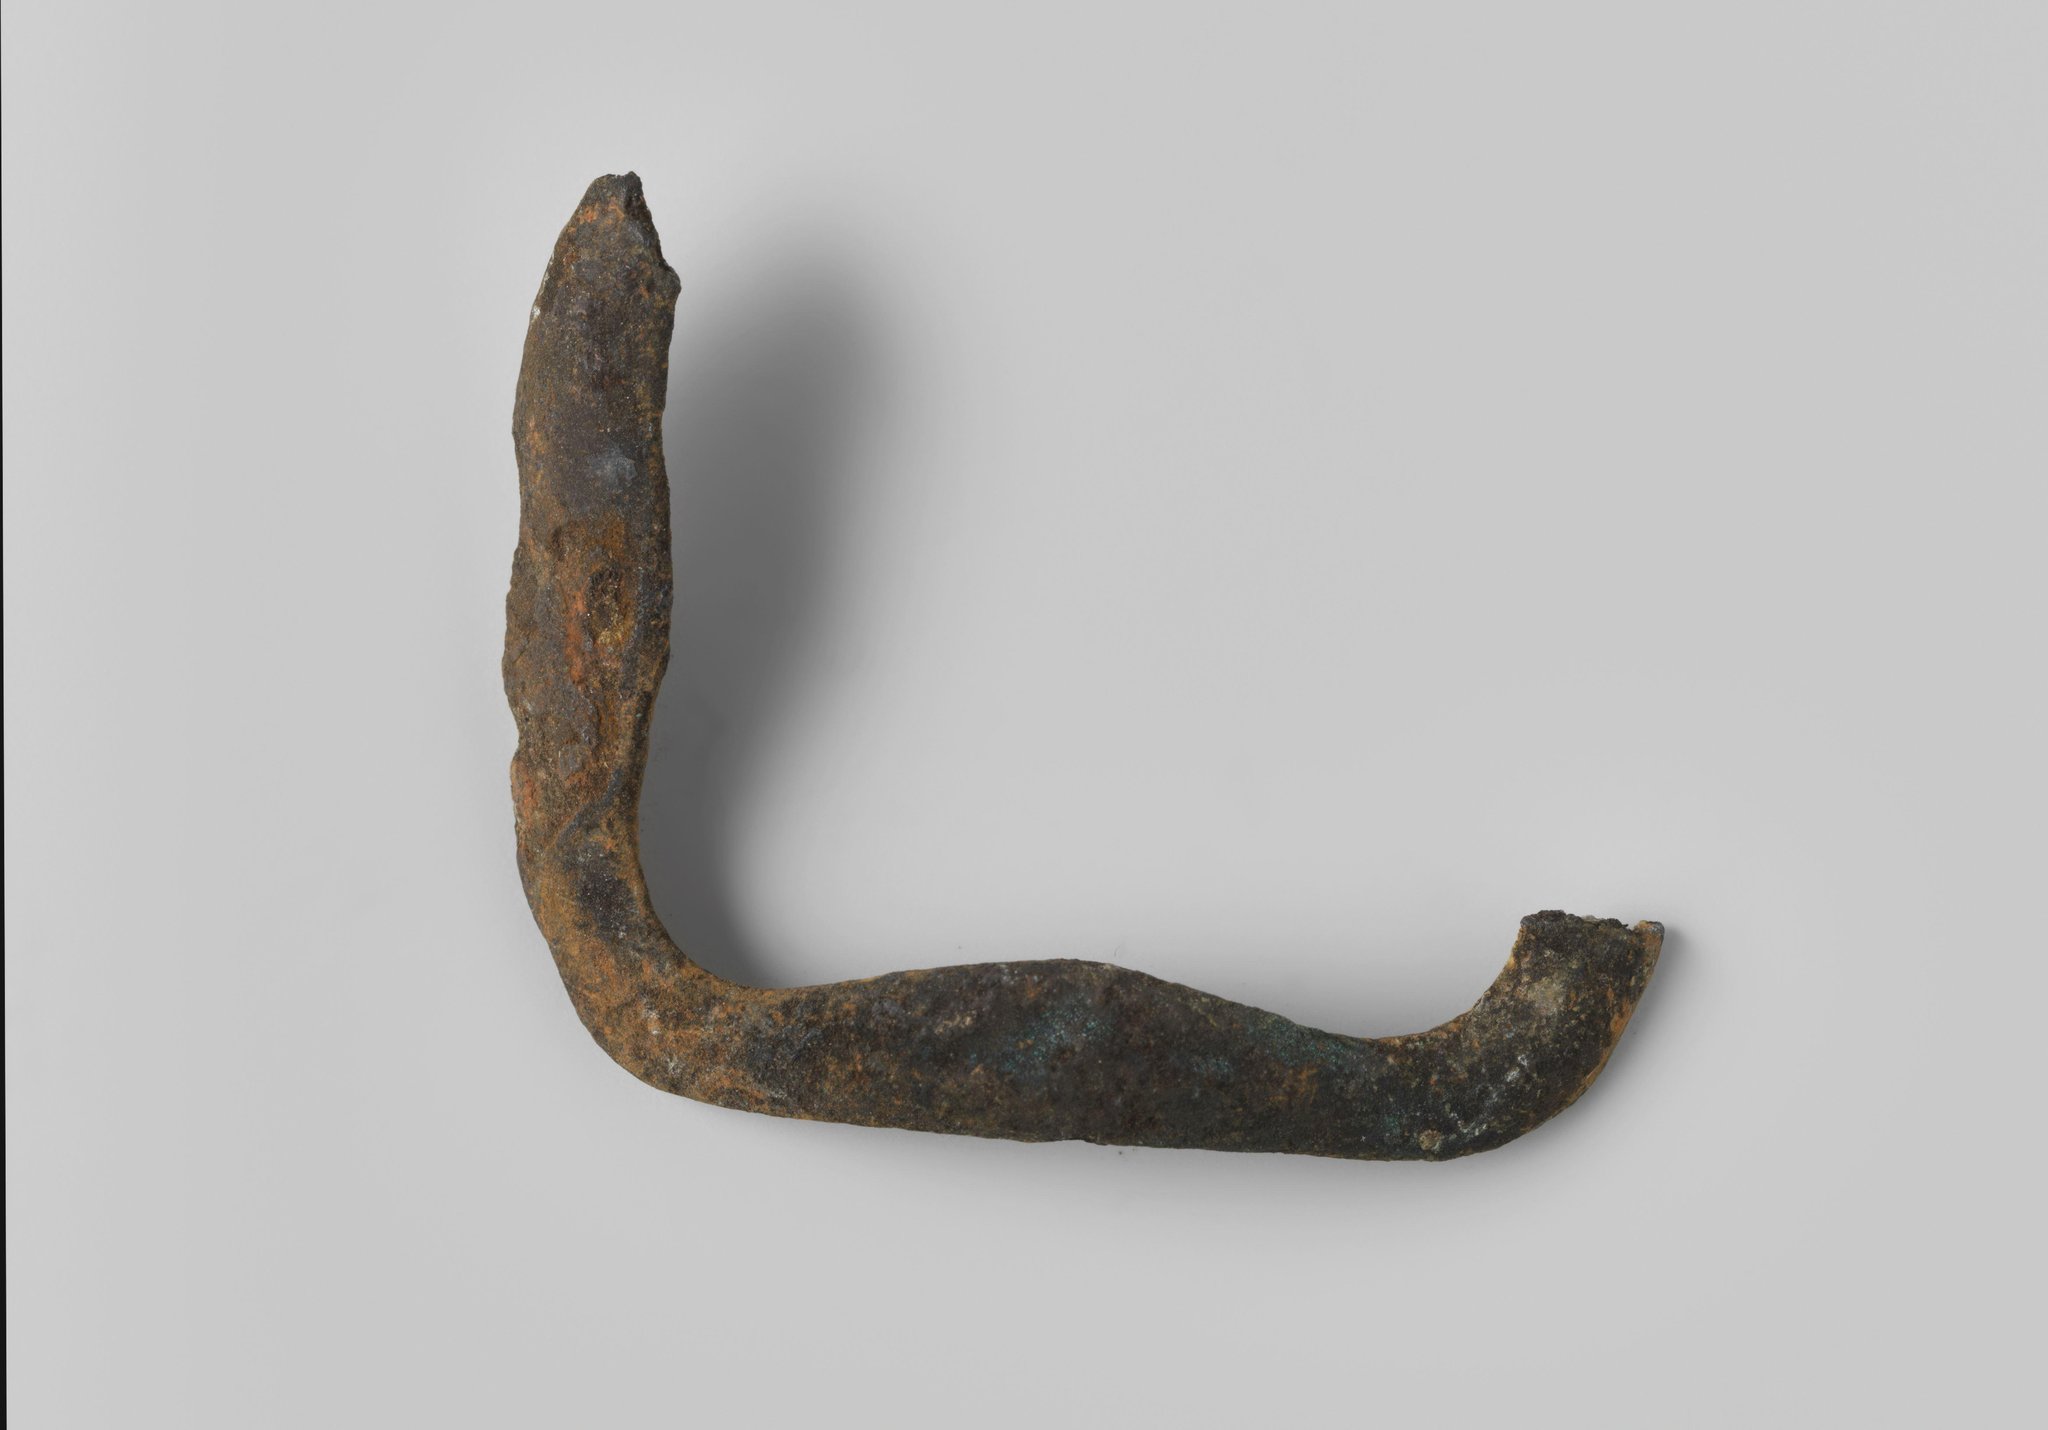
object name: shoe buckle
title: Fragment schoengesp uit het wrak van de Oost-Indiëvaarder Hollandia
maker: Anonymous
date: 1700-1743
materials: copper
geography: netherlands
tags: verenigde oostindische compagnie, hollandia (schip), annet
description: Buckle, chape buckle, shoe buckle; fragment of ring, id. NG 1980-27H1340.